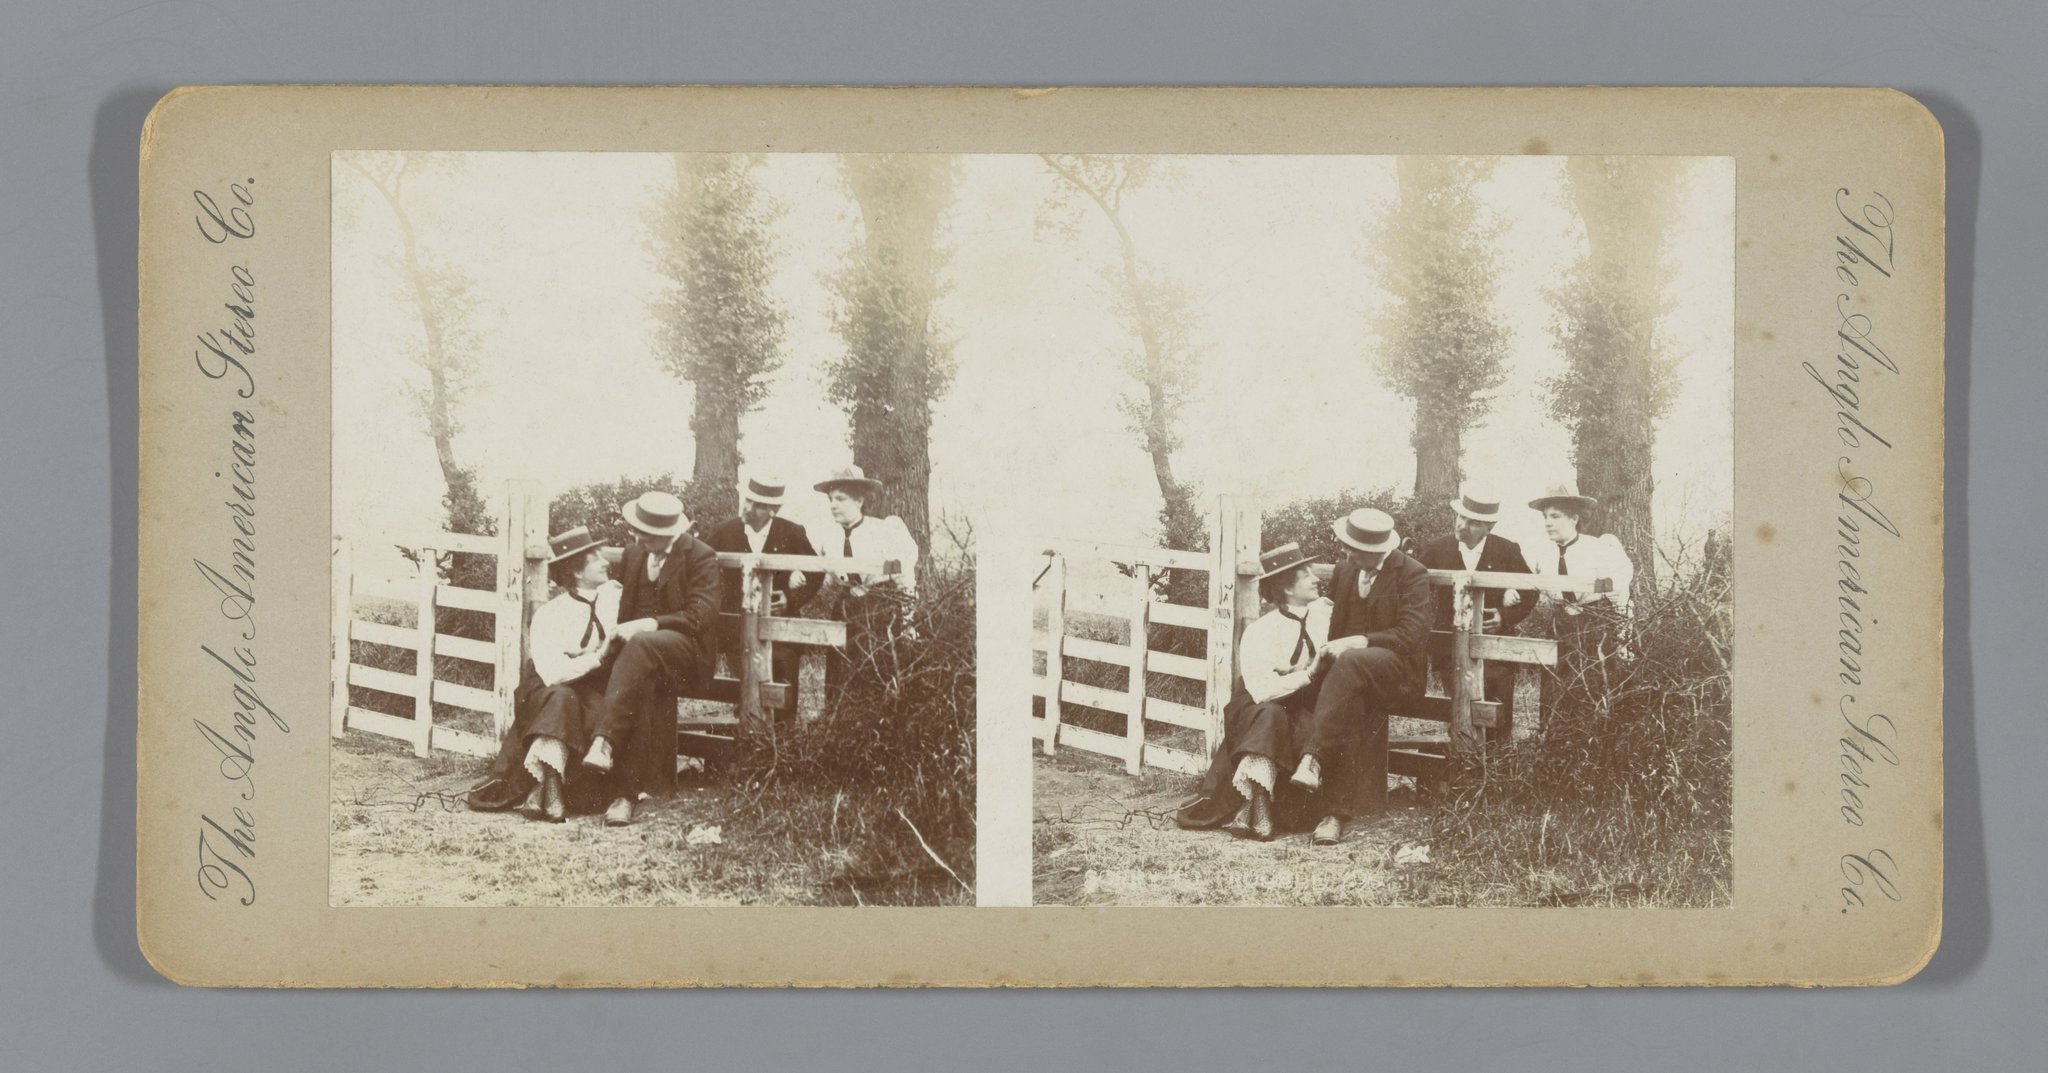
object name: stereograph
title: Twee paren bij hek in bos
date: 1890-1910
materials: cardboard, photographic support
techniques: gelatin silver print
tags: gate, entrance, couple of lovers